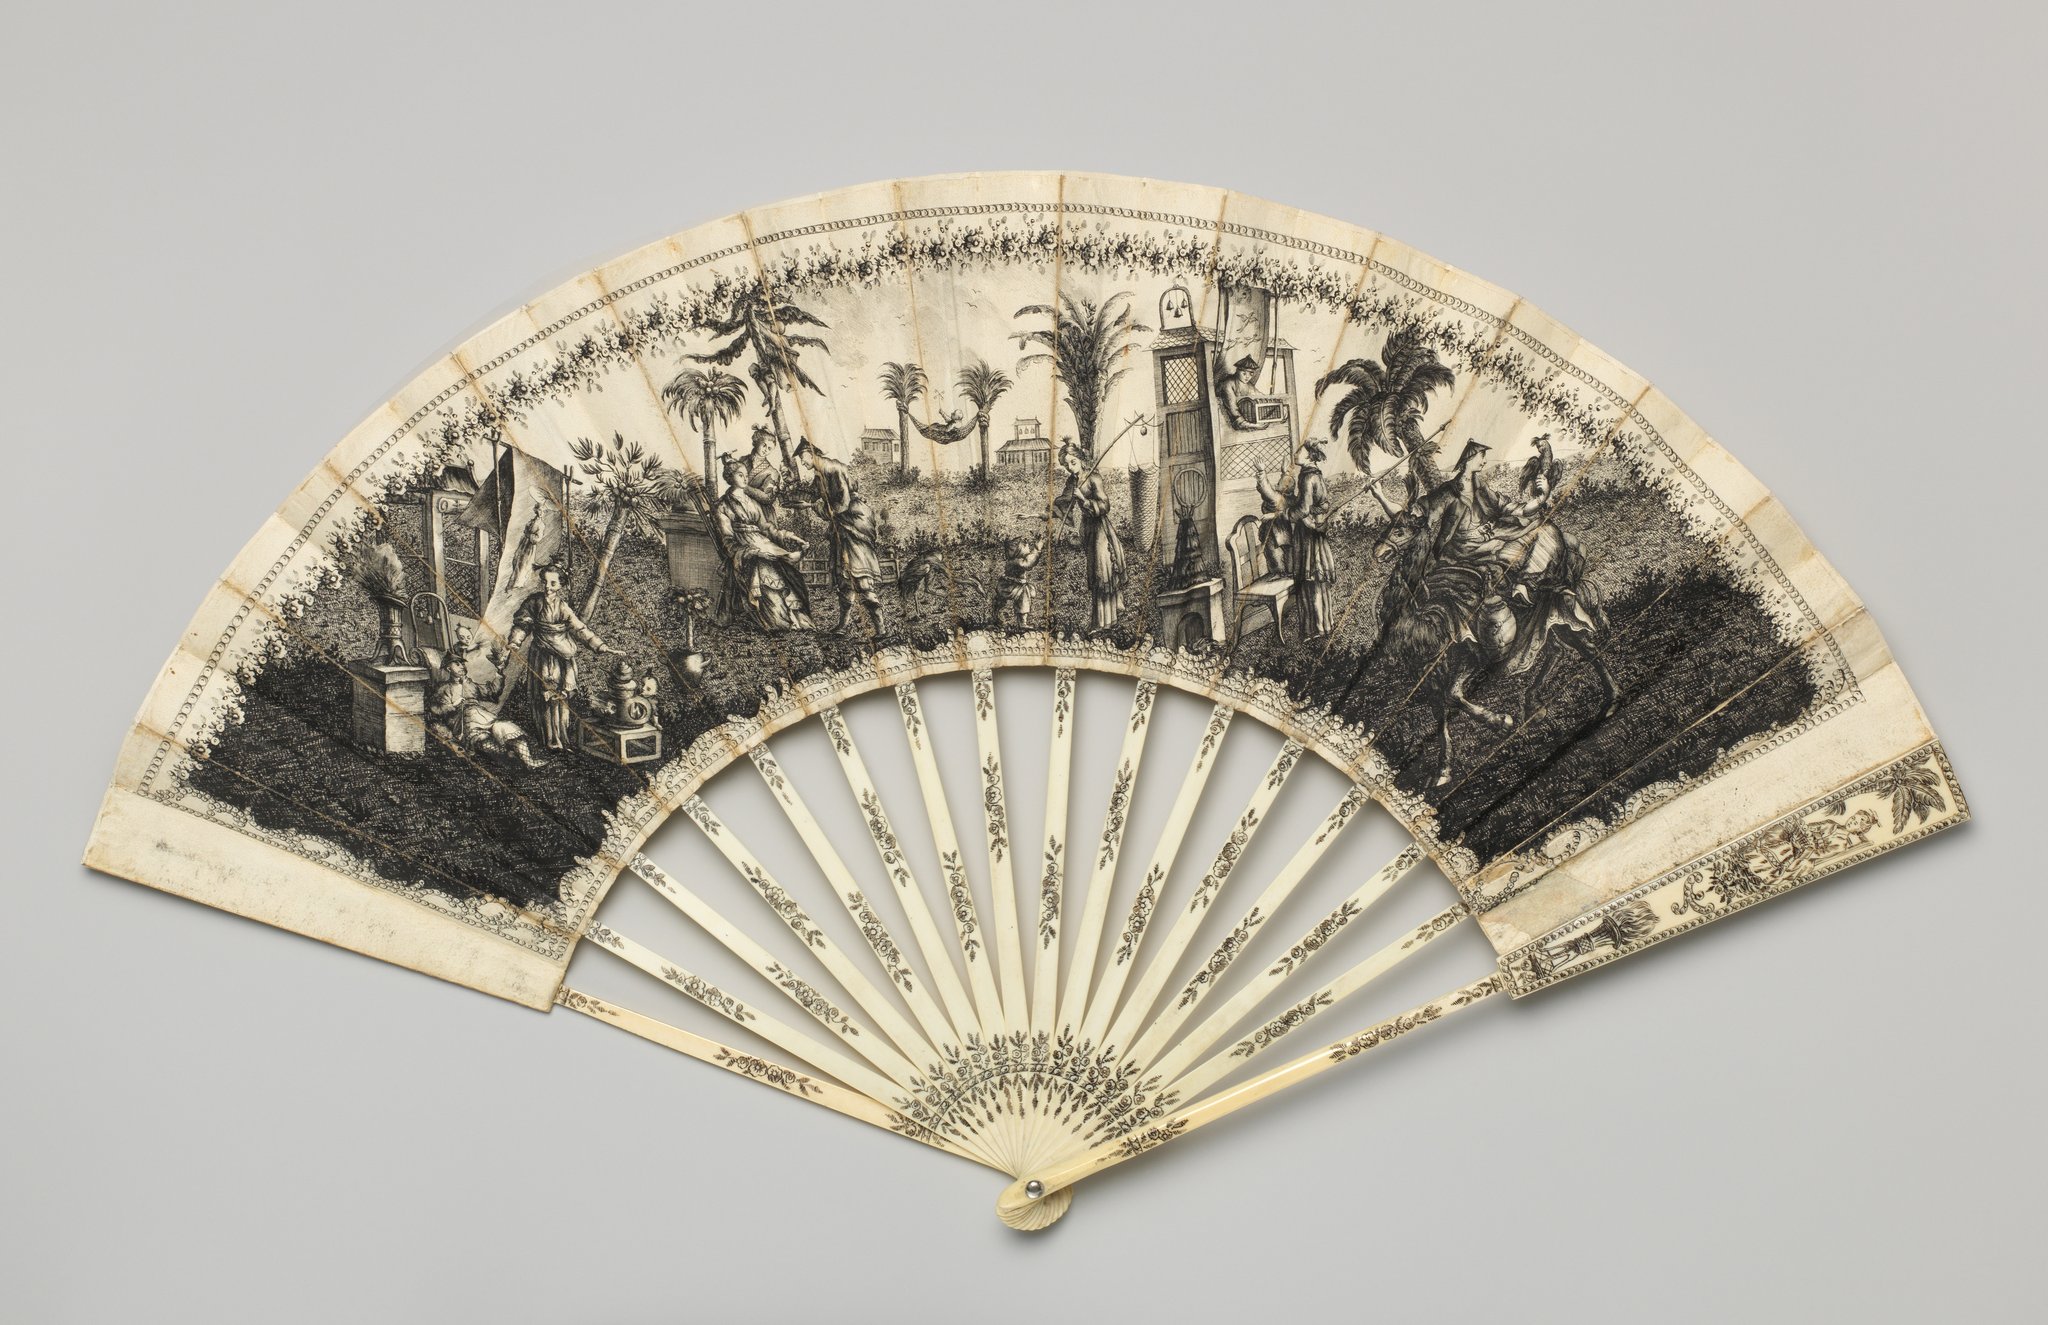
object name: fan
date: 1785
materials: ivory, parchment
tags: chinoiserie,children,men,women,camels